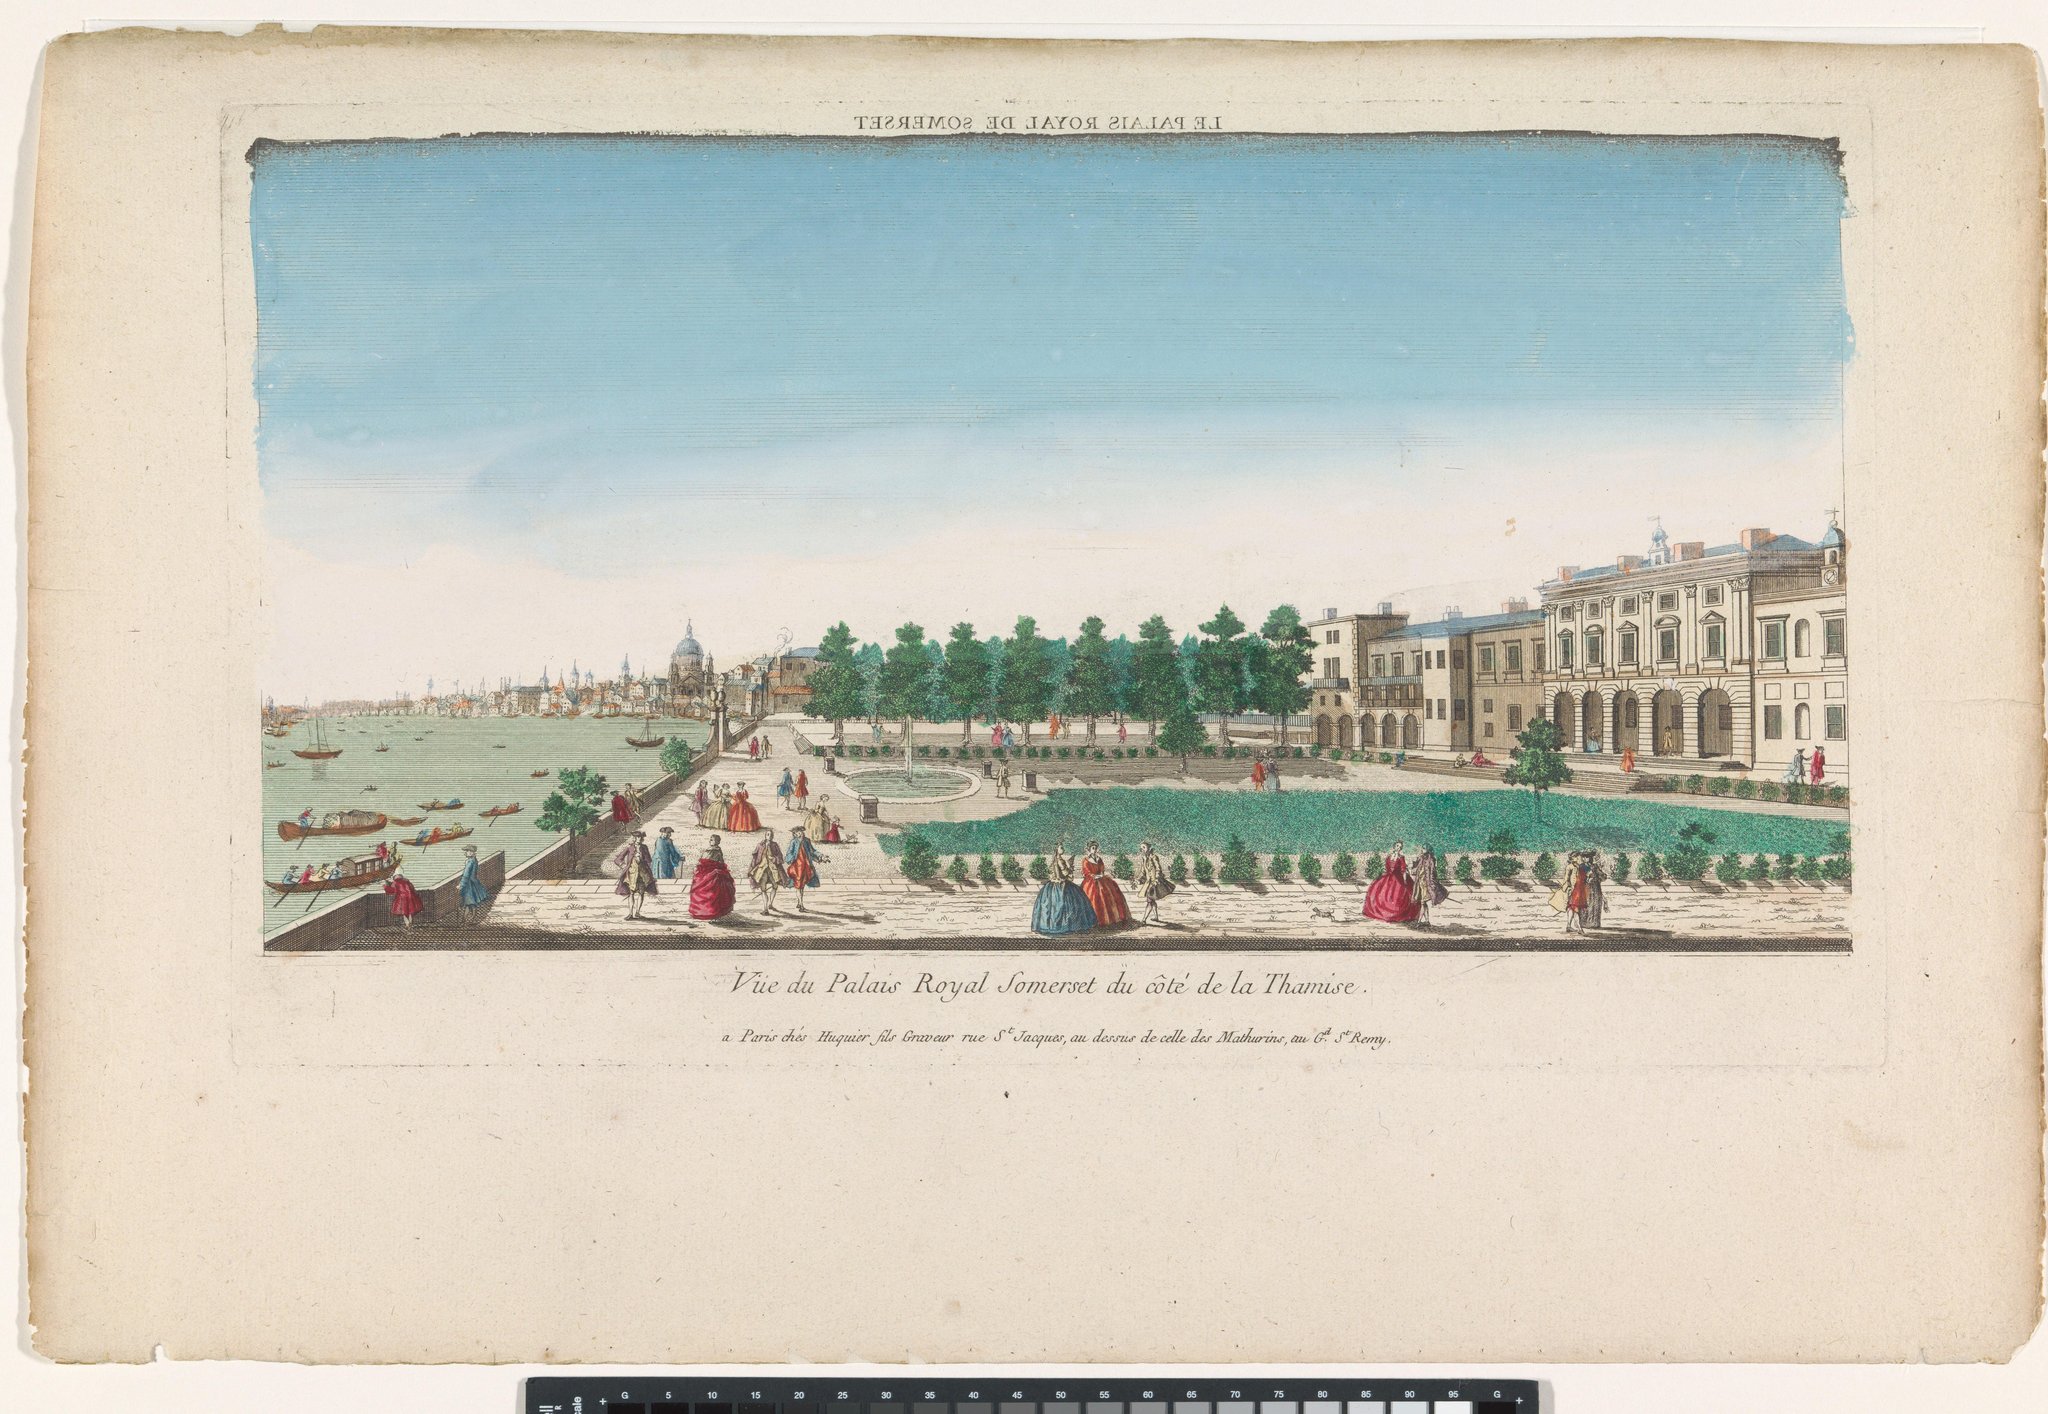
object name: print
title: Le Palais Royal de Somerset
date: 1735-1805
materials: paper, watercolor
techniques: brush, etching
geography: france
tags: sailing-ship, sailing-boat, garden, rowing-boat, canoe, etc., civic architecture; edifices; dwellings, canals, waters (in city) (+ city(-scape) with figures, staffage), thames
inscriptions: collector's mark: Lugt 2166